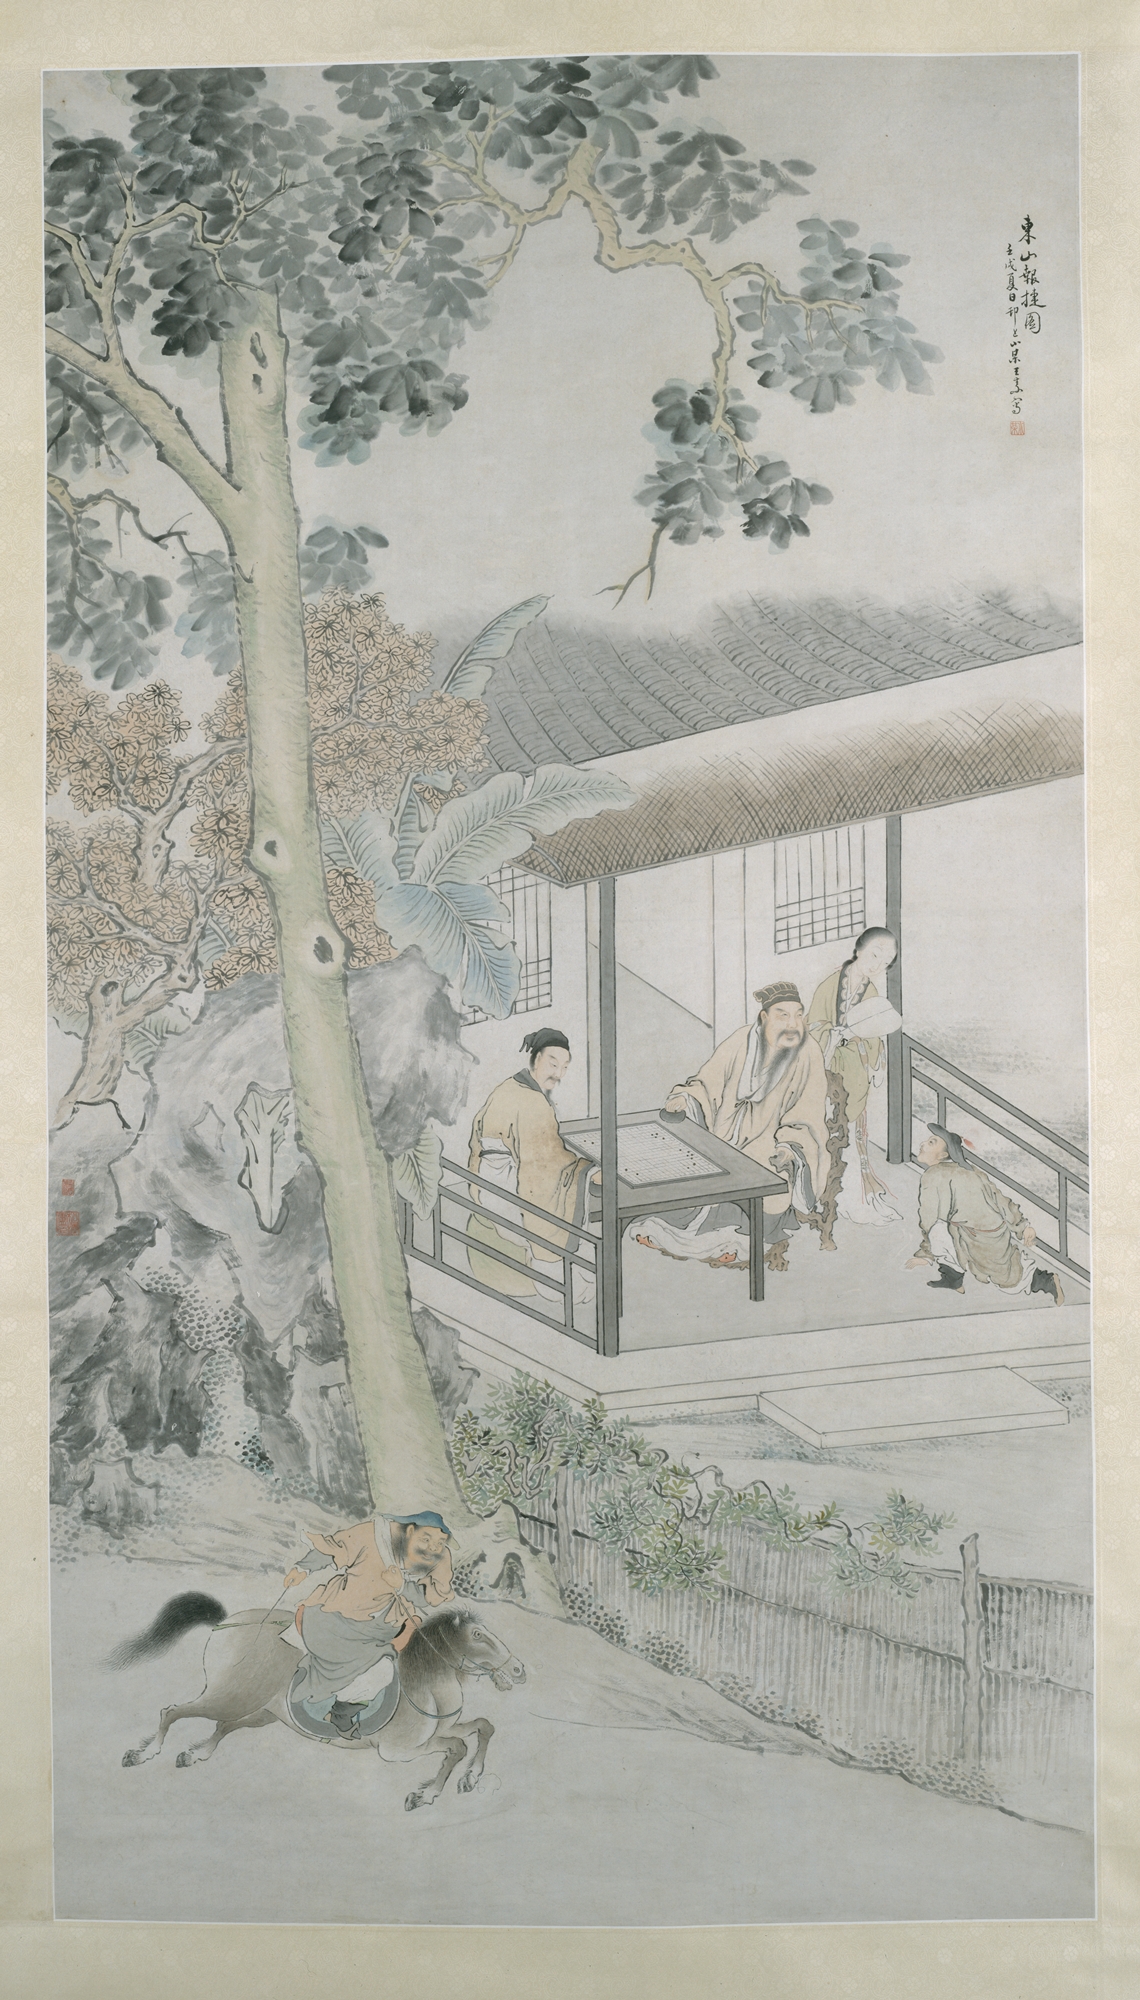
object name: hanging scroll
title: Bringing the Message of Victory to Dongshan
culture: chinese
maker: wang su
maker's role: artist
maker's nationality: chinese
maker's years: 1794-1877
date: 1862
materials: ink, paper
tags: men,women,horses,games